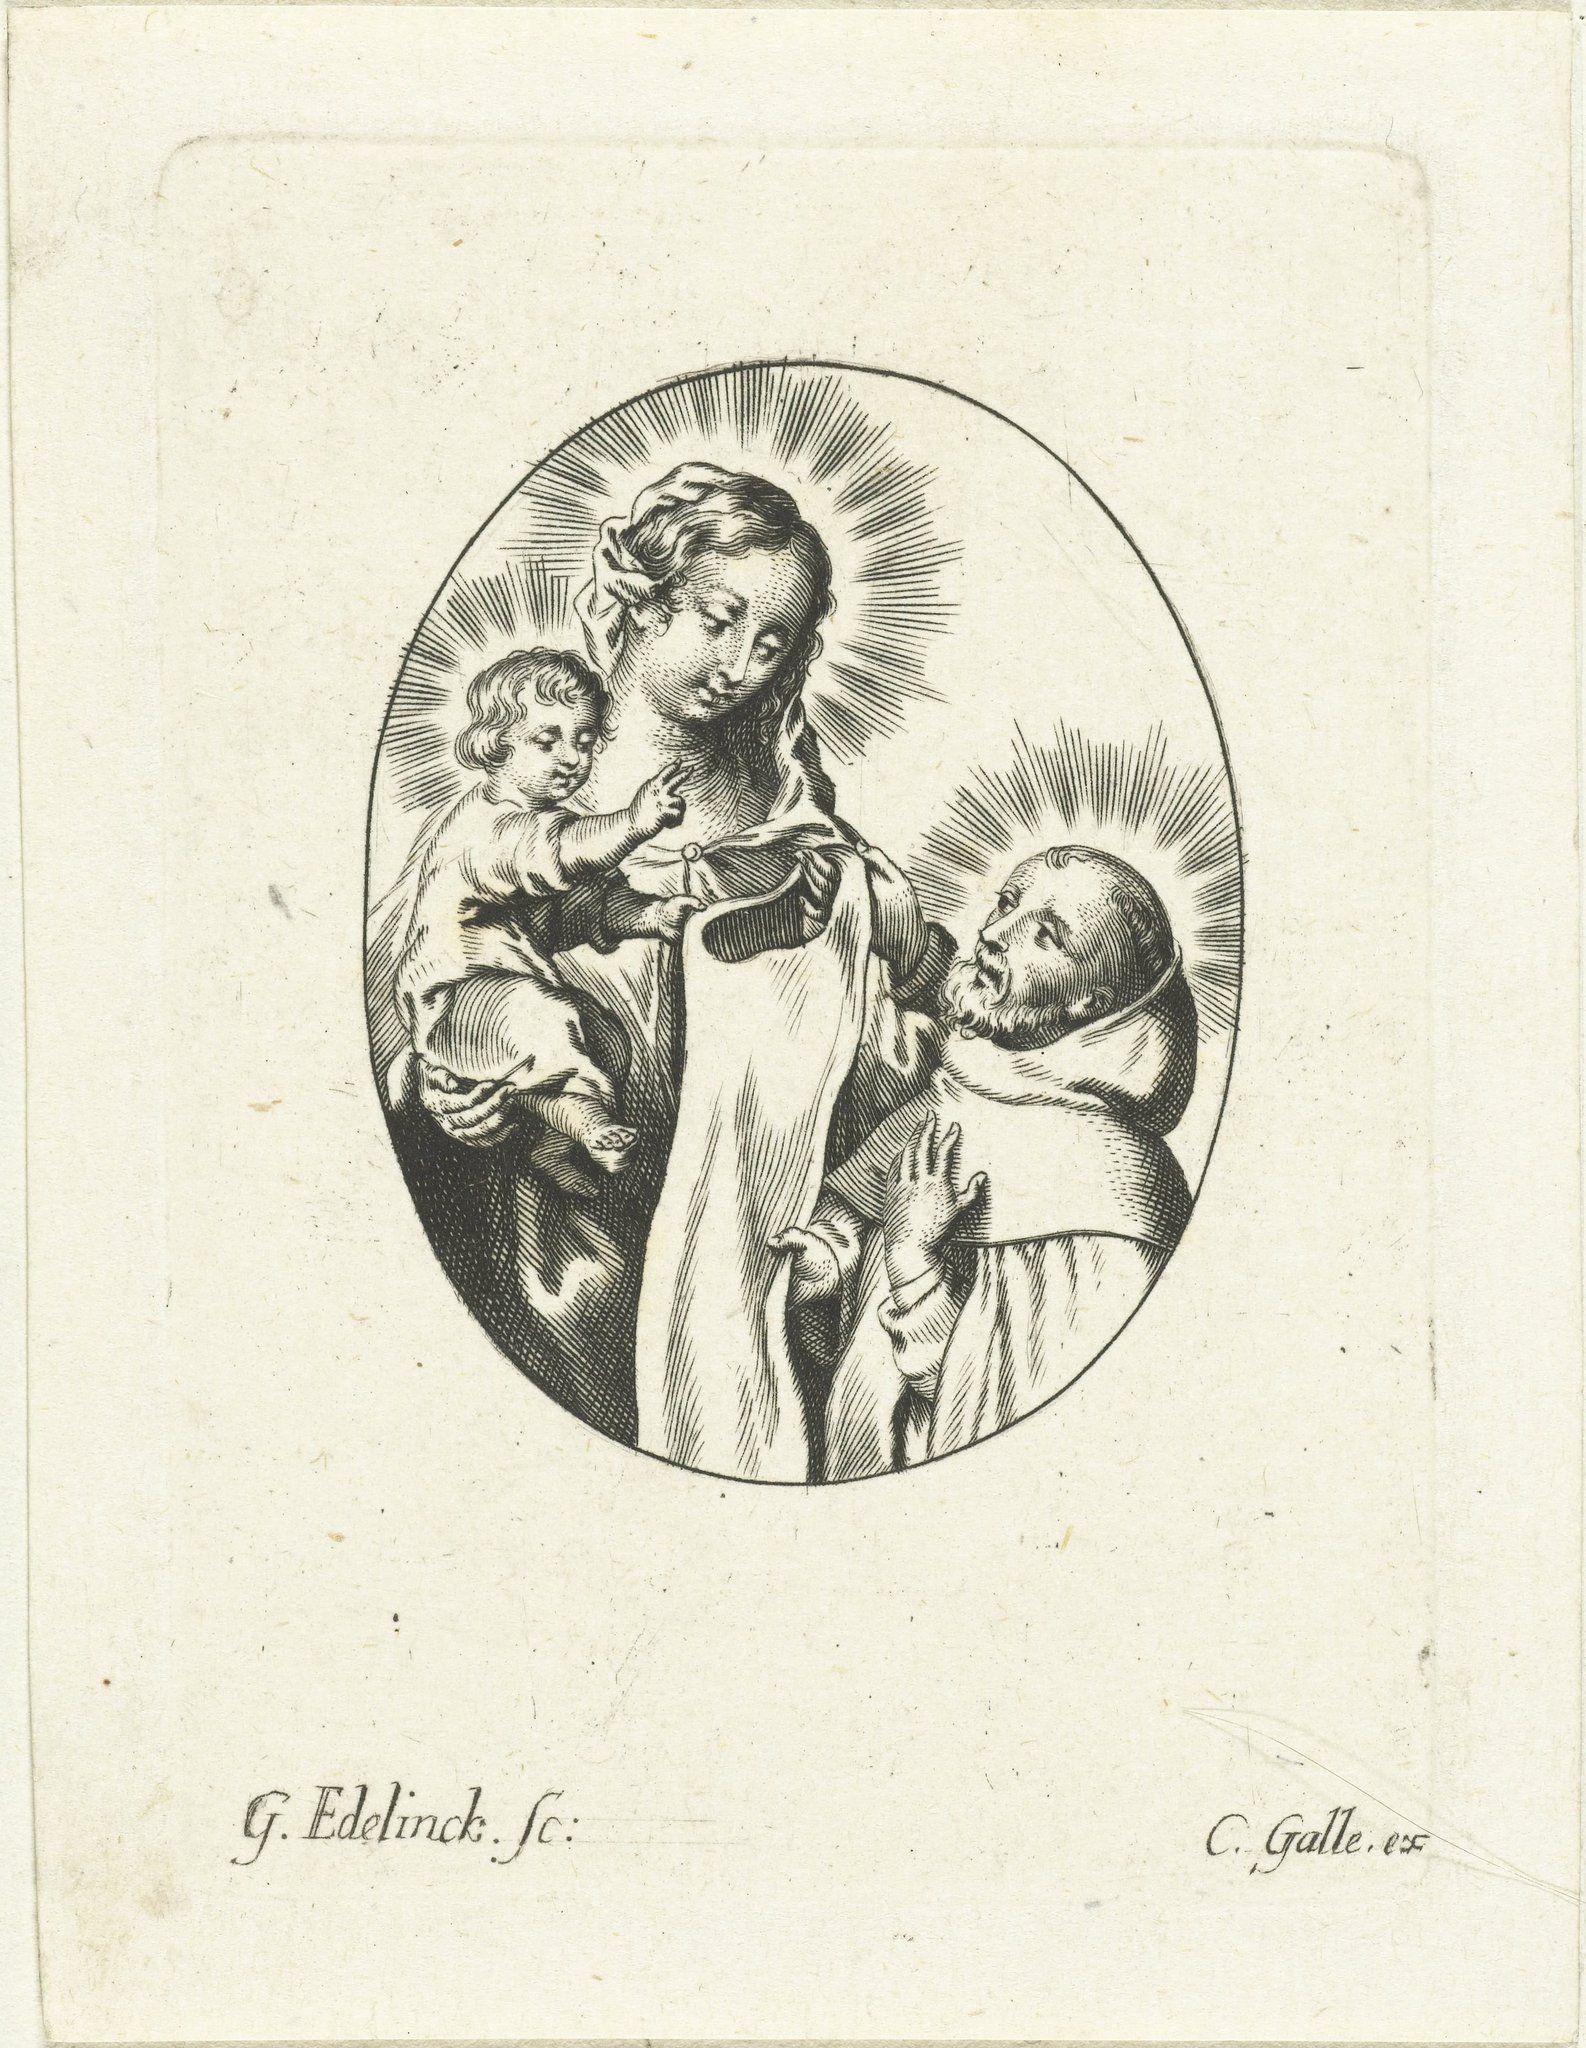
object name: print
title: Maria met kind aanbeden door een geestelijke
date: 1652-1666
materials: paper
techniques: engraving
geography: antwerp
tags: madonna (i.e. mary with the christ-child) accompanied or surrounded by others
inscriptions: collector's mark: Lugt 240